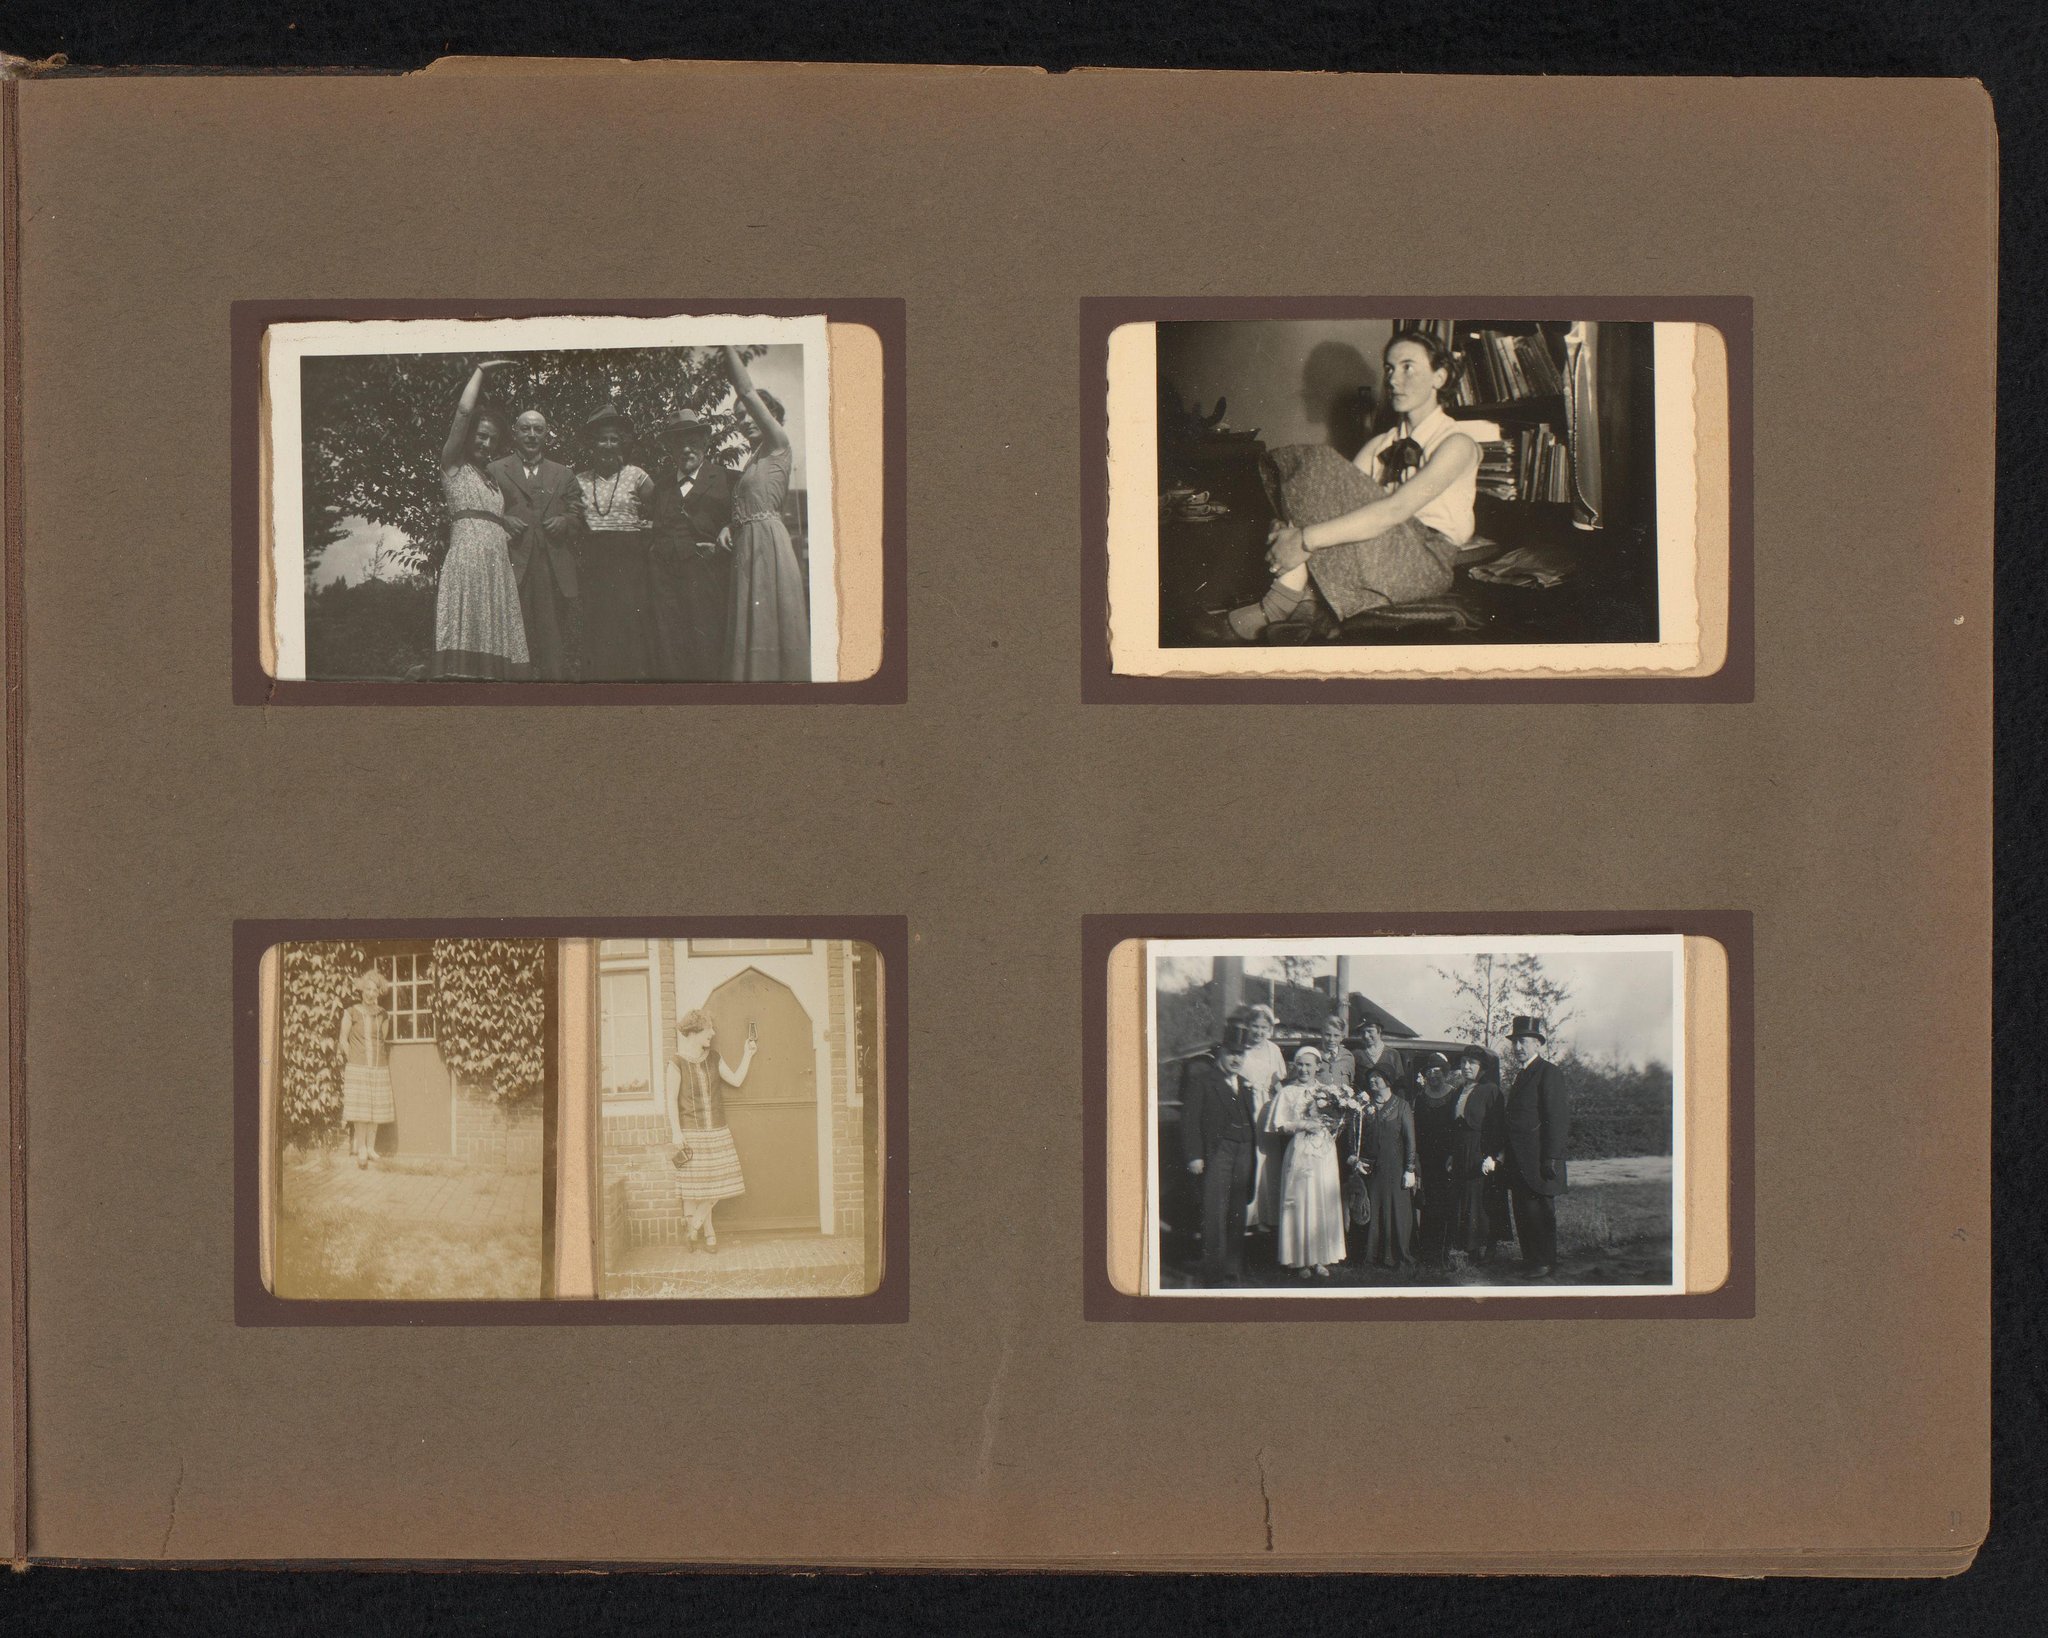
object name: album leaf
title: Vijf familiefoto's, onder andere bij een huwelijk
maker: Anonymous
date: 1920-1950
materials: paper, cardboard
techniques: gelatin silver print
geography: netherlands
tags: family group, especially parents with their child(ren), bride and groom in wedding-dress, historical persons not known by name, netherlands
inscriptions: number: ‘64’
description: Deze foto's maken deel uit van een album.